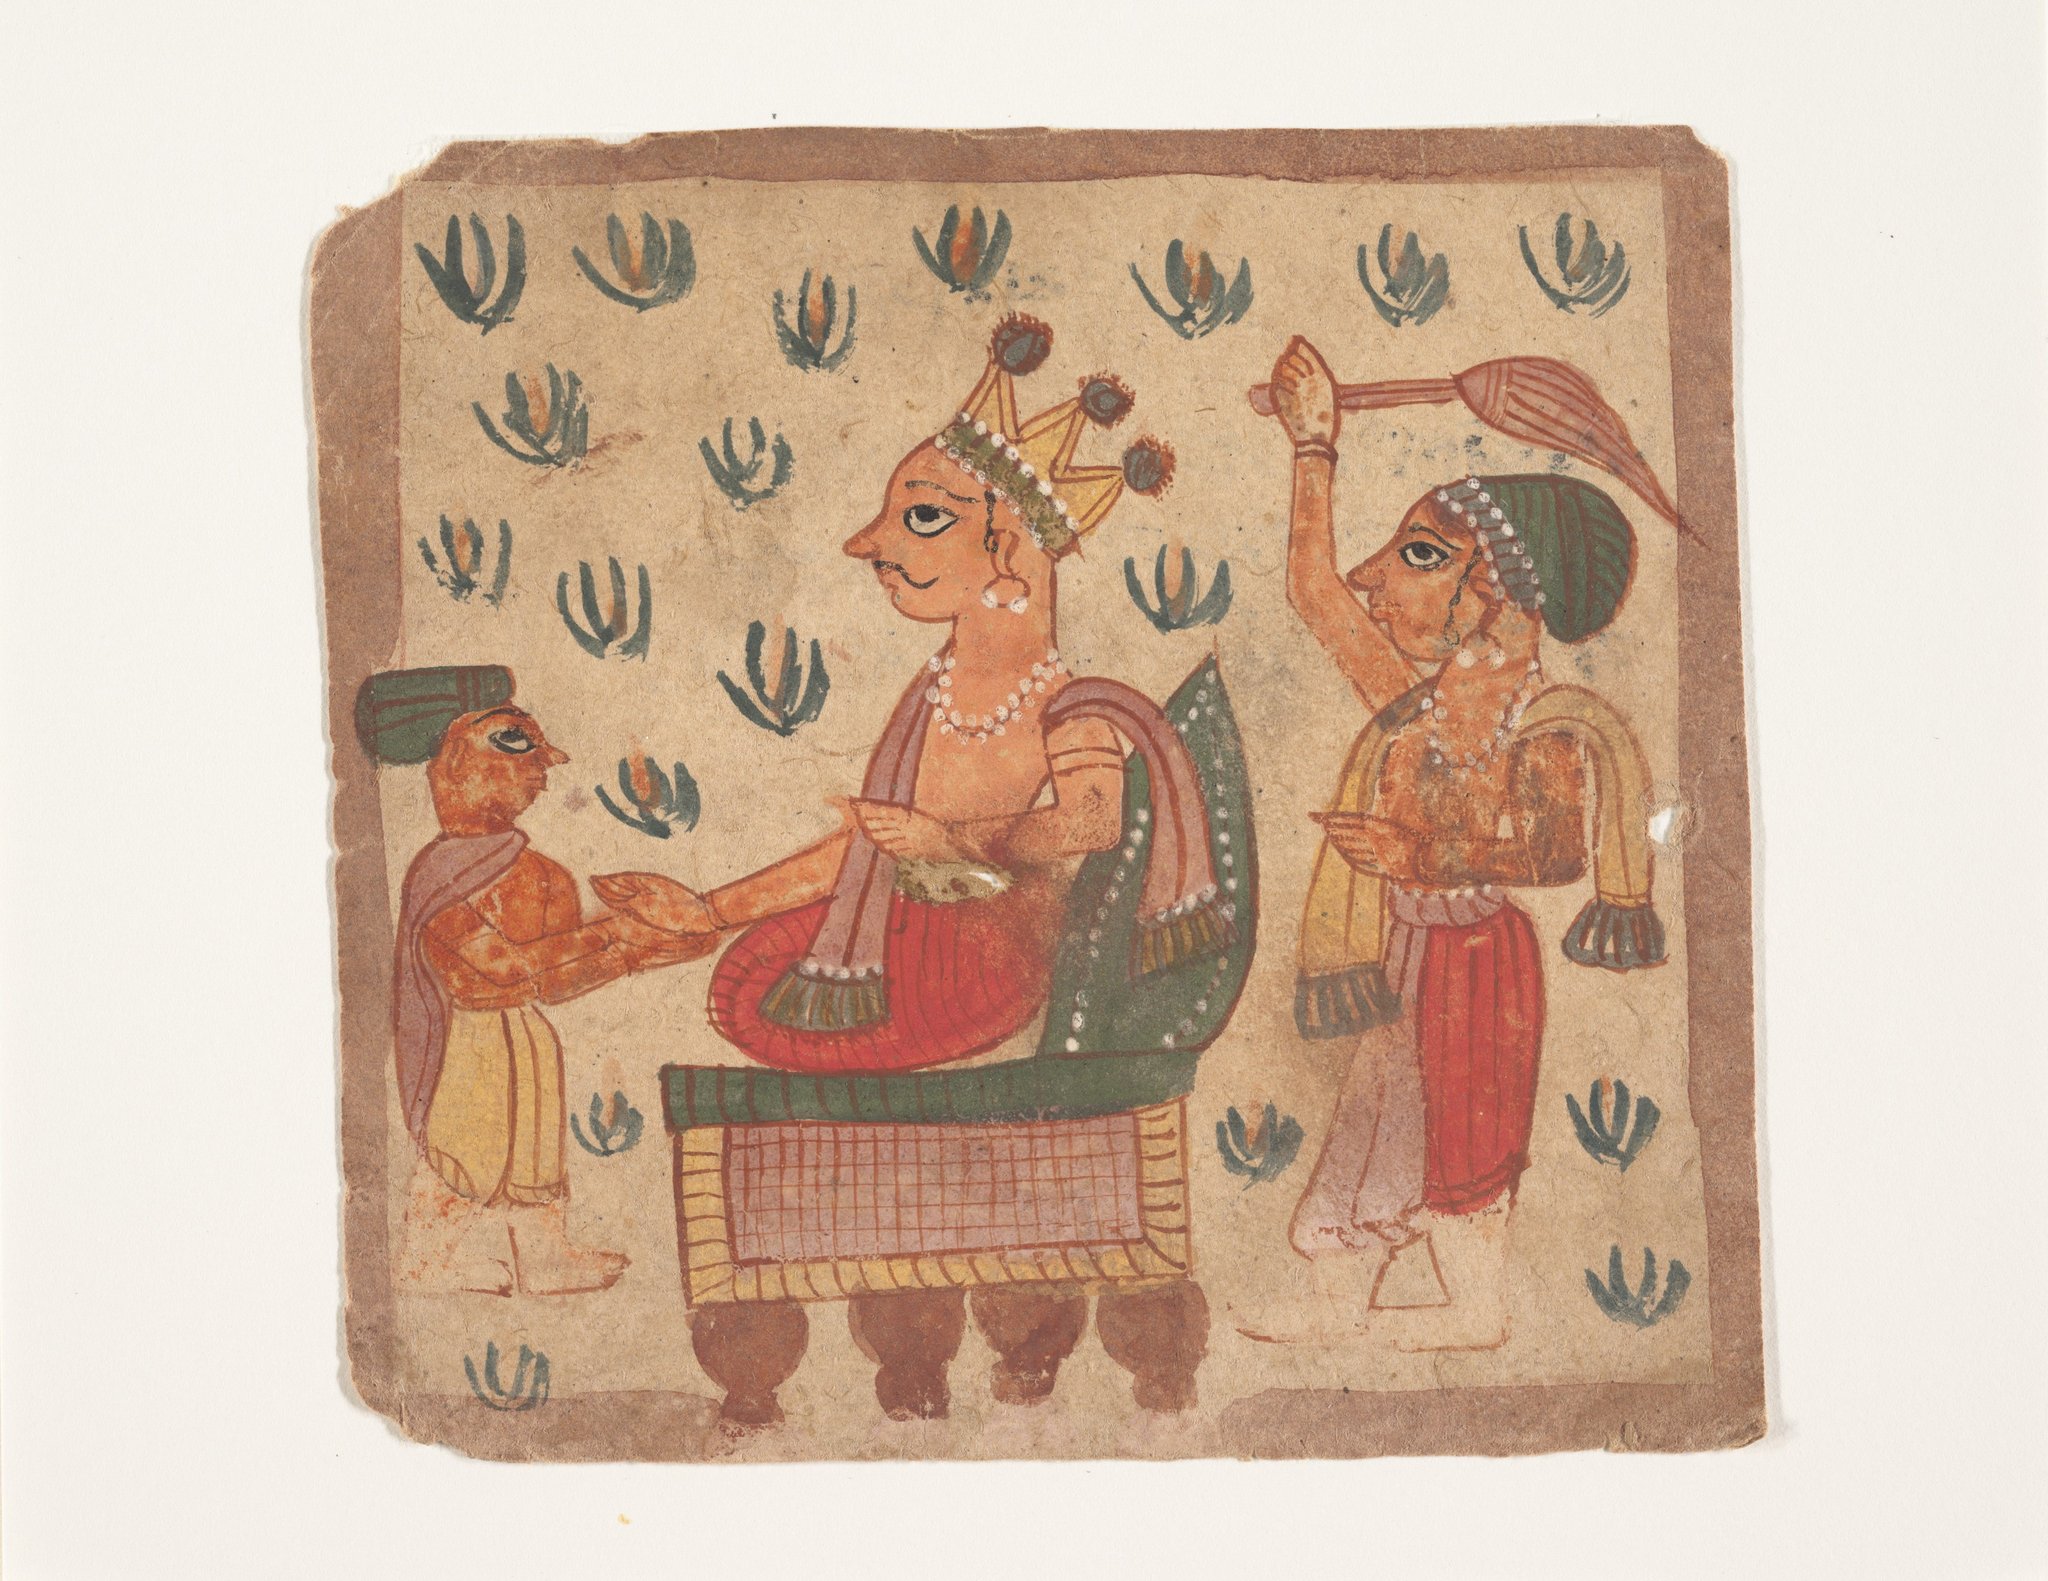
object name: painting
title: A King Seated on His Throne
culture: indian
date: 1725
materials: ink, paper, watercolor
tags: kings,men,thrones